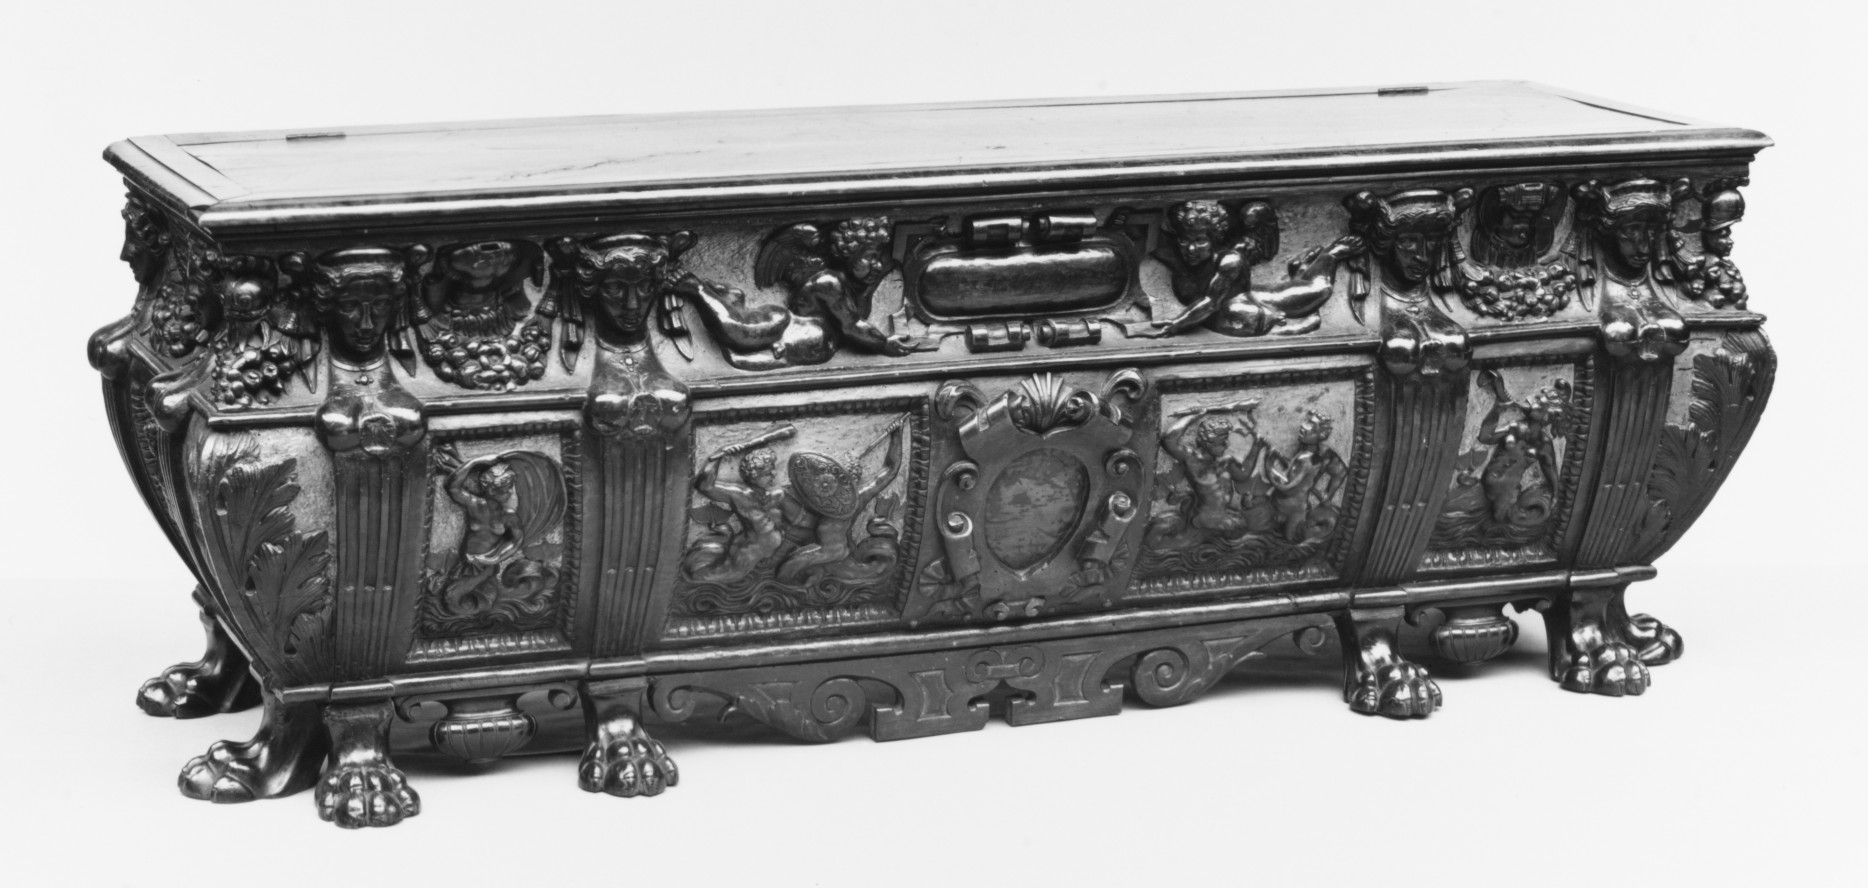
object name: marriage chest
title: Marriage chest (cassone) (one of a pair)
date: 1551-1575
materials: wood